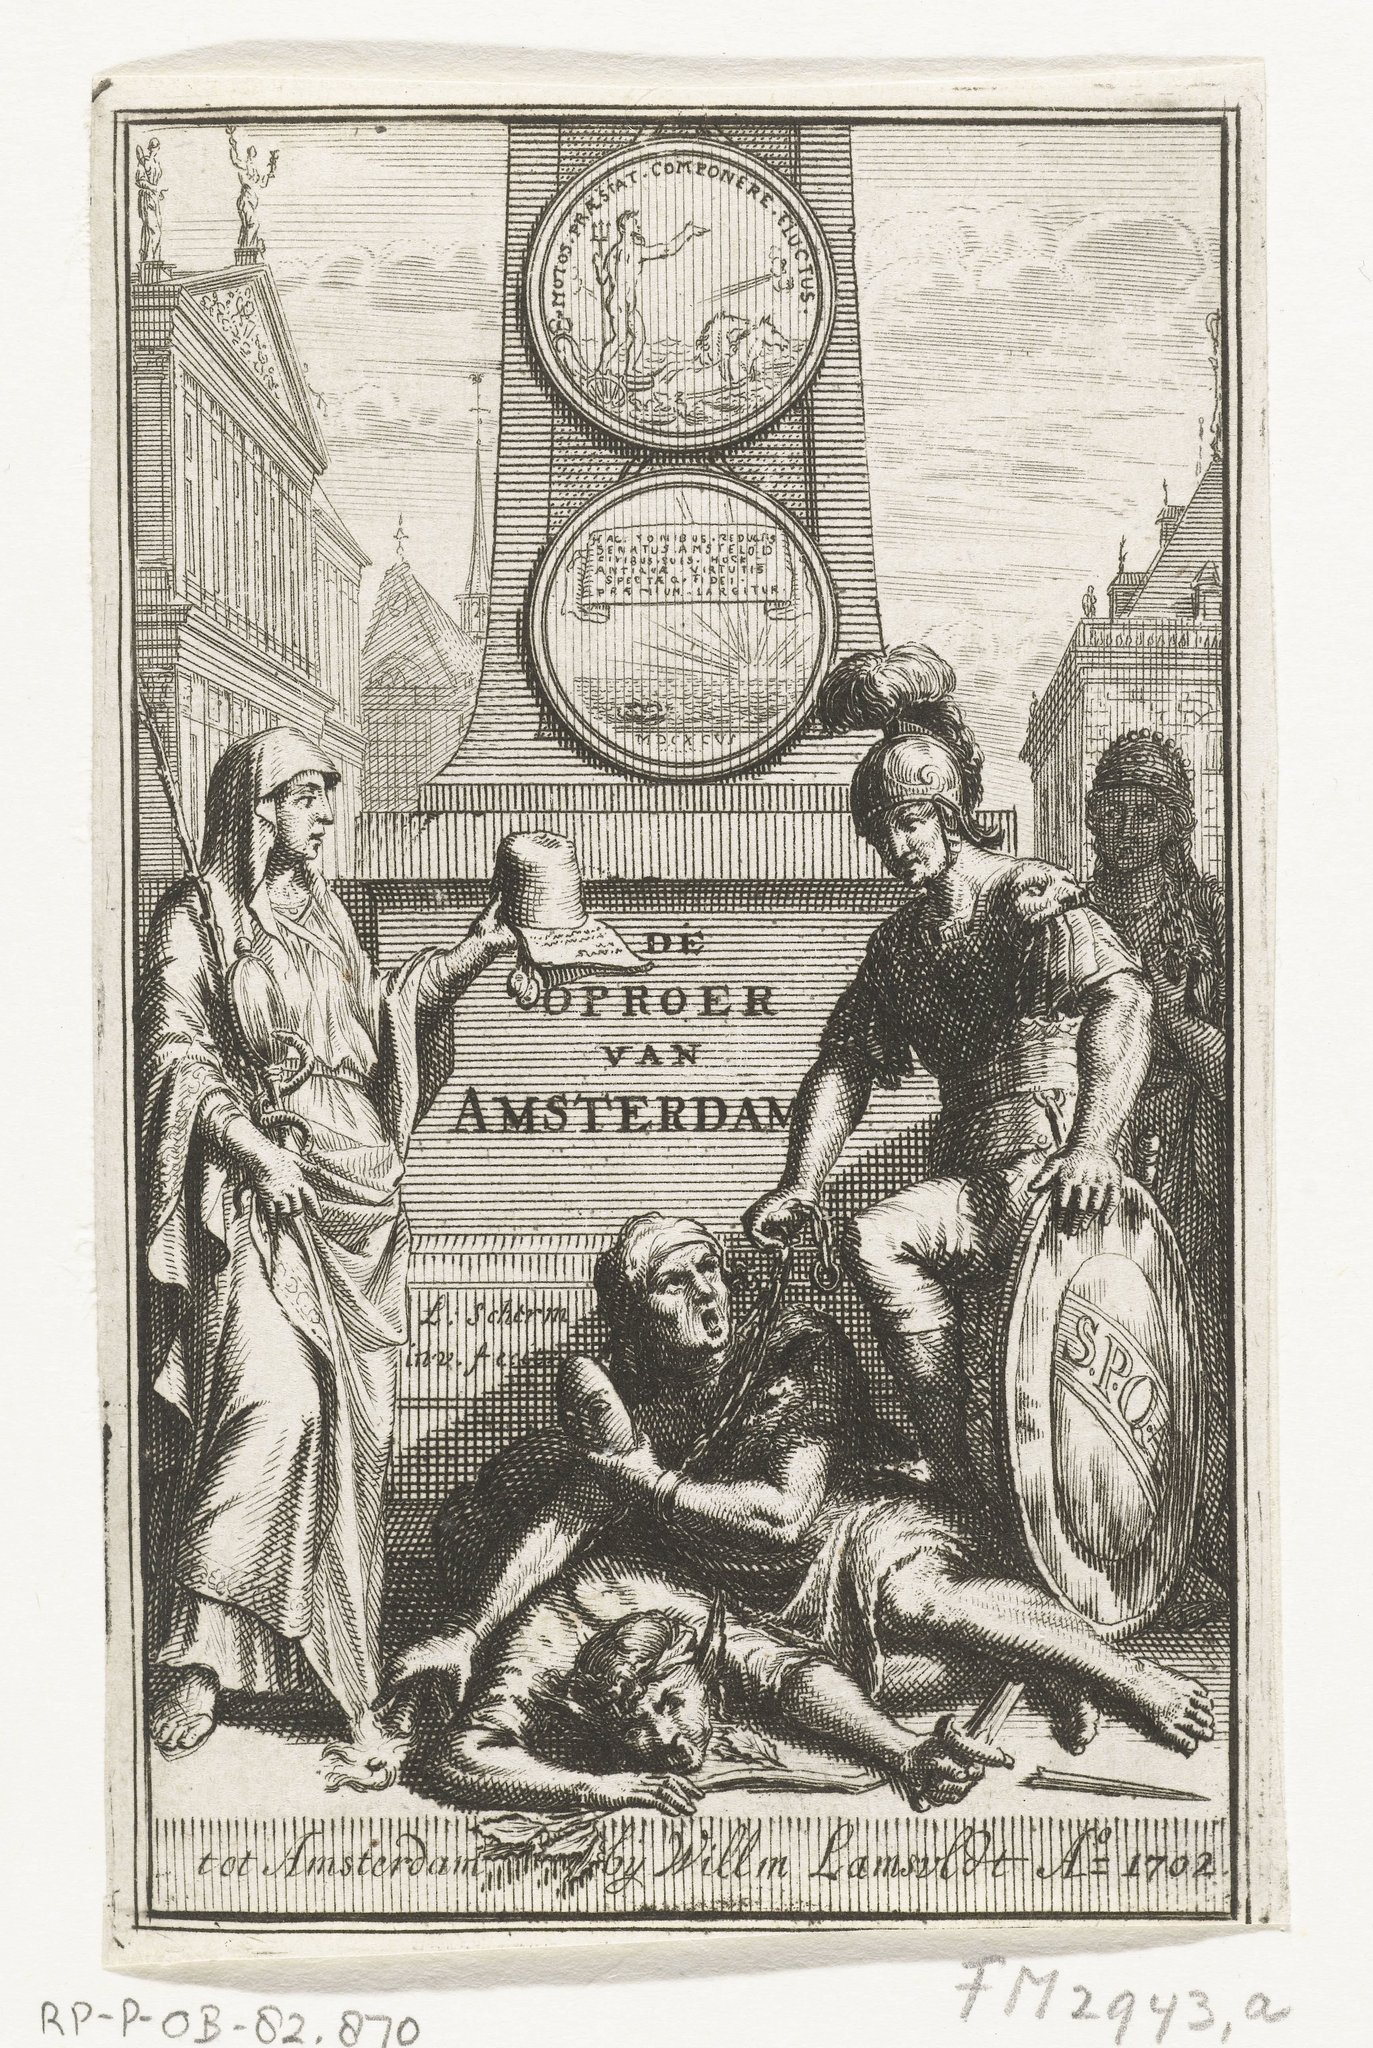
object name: titelblad, titelpagina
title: Allegorische figuren voor een obelisk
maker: laurens scherm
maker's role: draughtsman, print maker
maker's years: 1671-1702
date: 1702-1733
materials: paper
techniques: engraving, etching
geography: amsterdam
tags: unsuccessful revolution or revolt, suppression of revolutionary activity, obelisk, needle, title-page, townhall, the soldier; the soldier's life, prisoner with hands bound, prudentia (prudence) as roman personification, amsterdam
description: Allegorische voorstelling voor een obelisk waarin twee oproerkraaiers (van het Aansprekersoproer uit 1696) door een soldaat worden geketend en onderdrukt. Links staat Voorzichtigheid met een spiegel en een slang. Rechts staat de soldaat, op zijn schild staat de afkorting S.P.Q.A. (de senaat en het volk van Amsterdam). In zijn linkerhand heeft hij ketenen, waarmee hij de man voor hem geboeid heeft. Onder deze man ligt een man met ezelsoren en een gebroken dolk. Op de obelisk zijn twee medaillons met zeesymboliek te zien: boven Neptunus op zijn wagen en onder de zee. Links op de achtergrond het Stadhuis op de Dam.